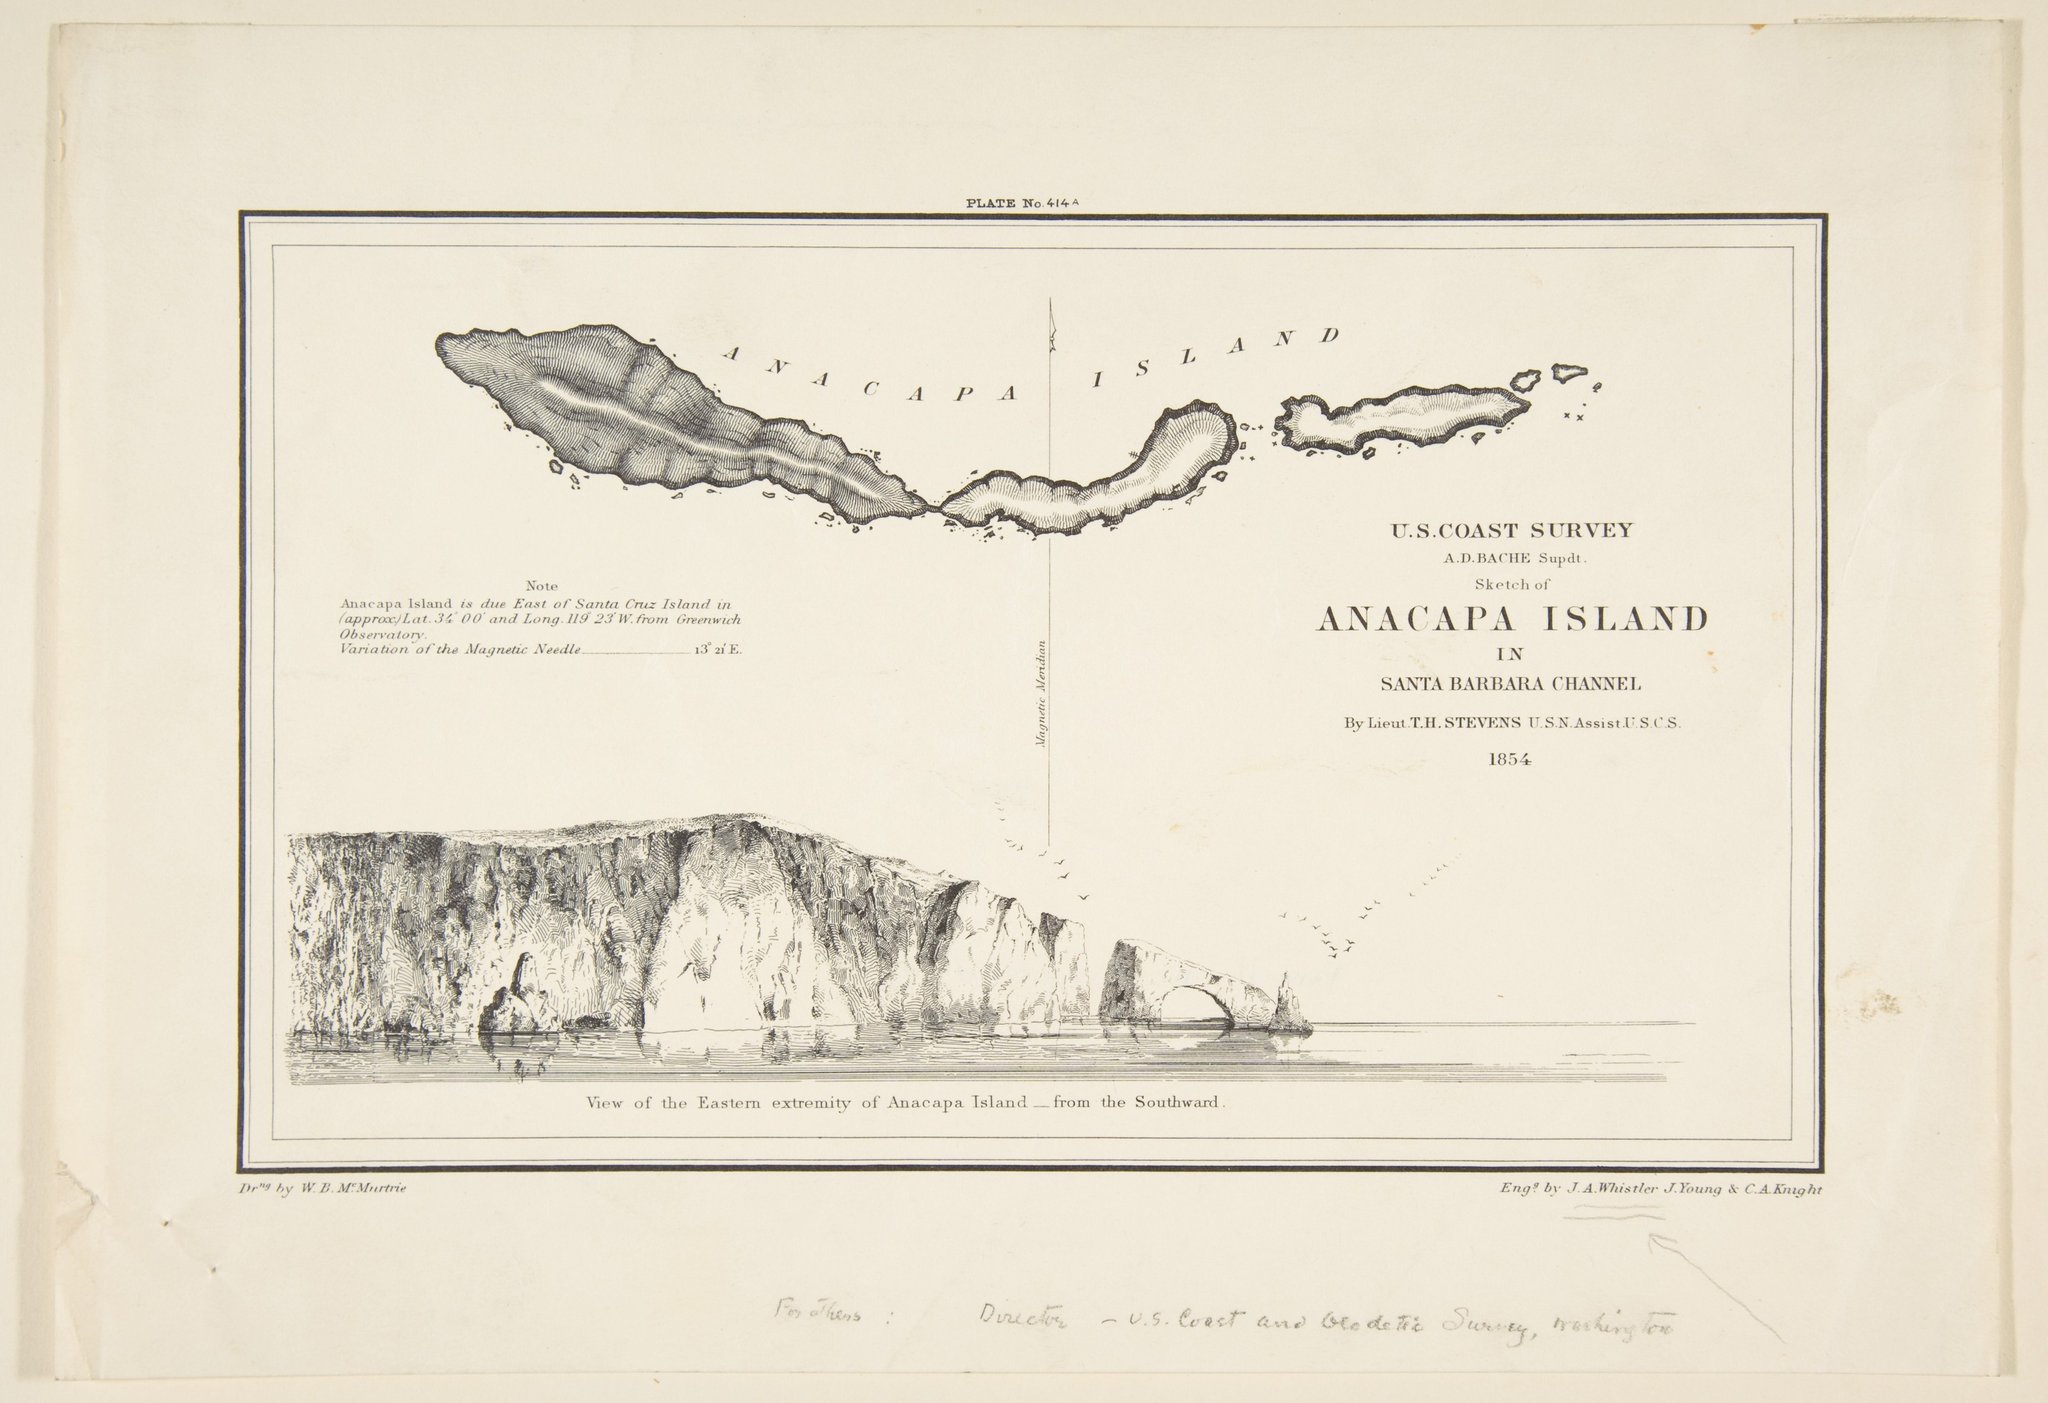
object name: print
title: U.S. Coast Survey...Sketch of Anapaca Island in Santa Barbara Channel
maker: james mcneill whistler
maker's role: artist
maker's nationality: american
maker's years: 1834-1903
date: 1854-1857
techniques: lithography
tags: maps